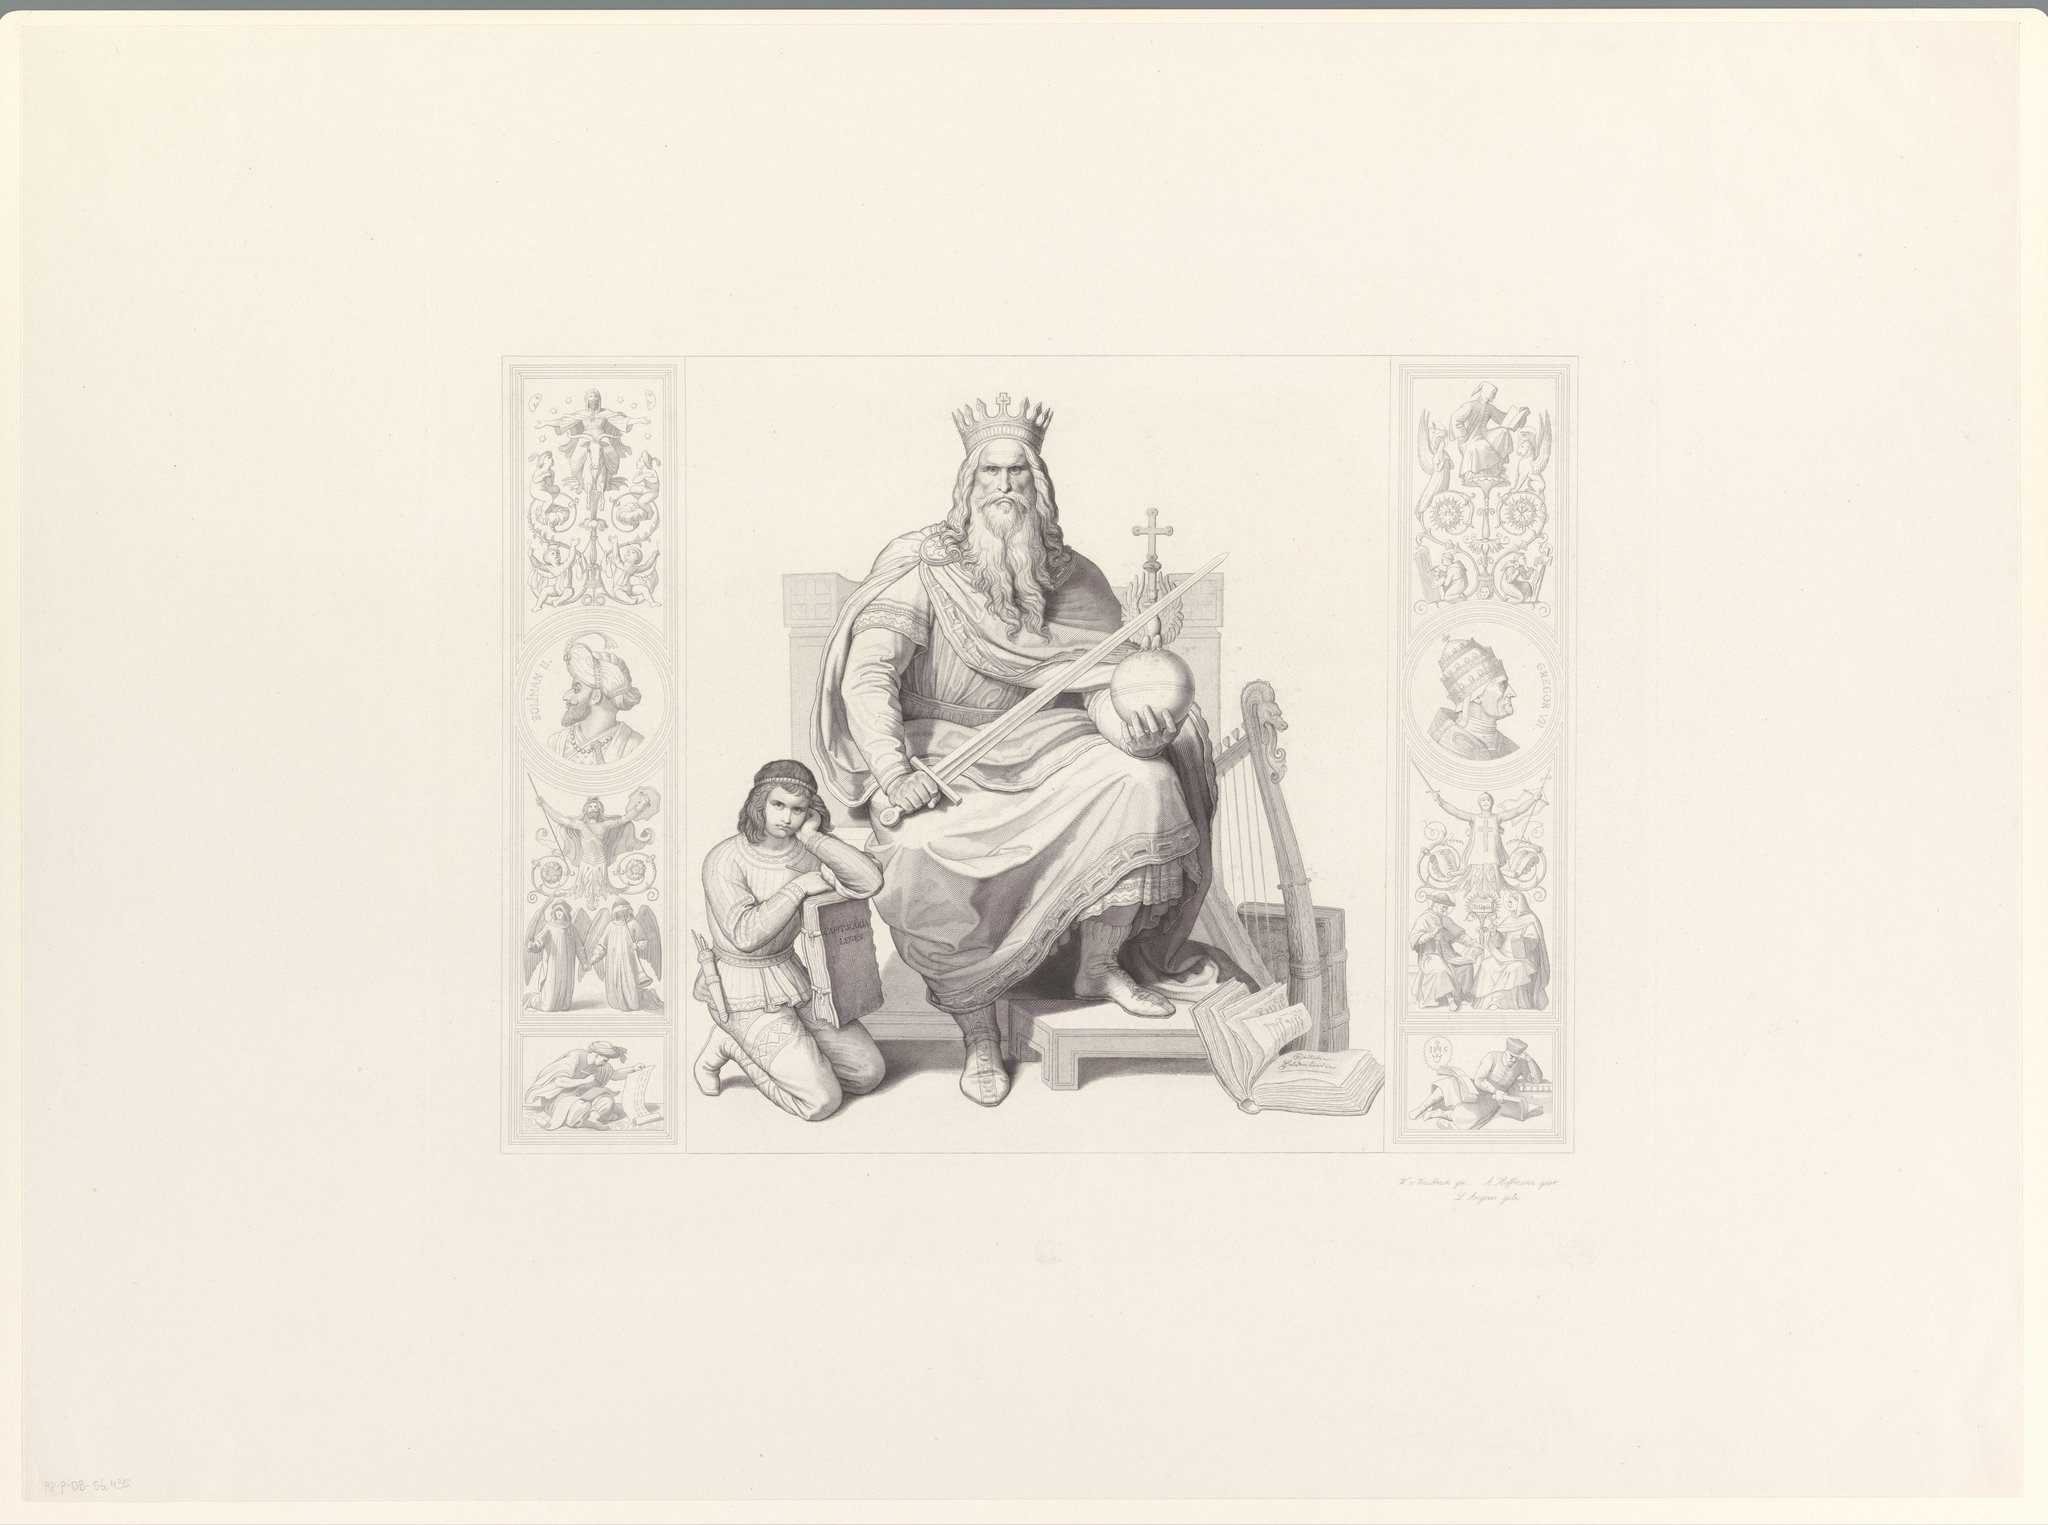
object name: print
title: Karel de Grote op een troon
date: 1820-1872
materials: paper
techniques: engraving, etching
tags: salerno, historical persons, ruler, sovereign, the holy roman emperor charlemagne; possible attributes: crown, model of church, orb, sceptre, sword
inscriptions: stamp: ‘DAC’, collector's mark: Lugt 2165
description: Aan weerszijden een portret van kalief Süleyman II en paus Gregor VII, in de marge ook ornamenten met religieuze ondertoon.